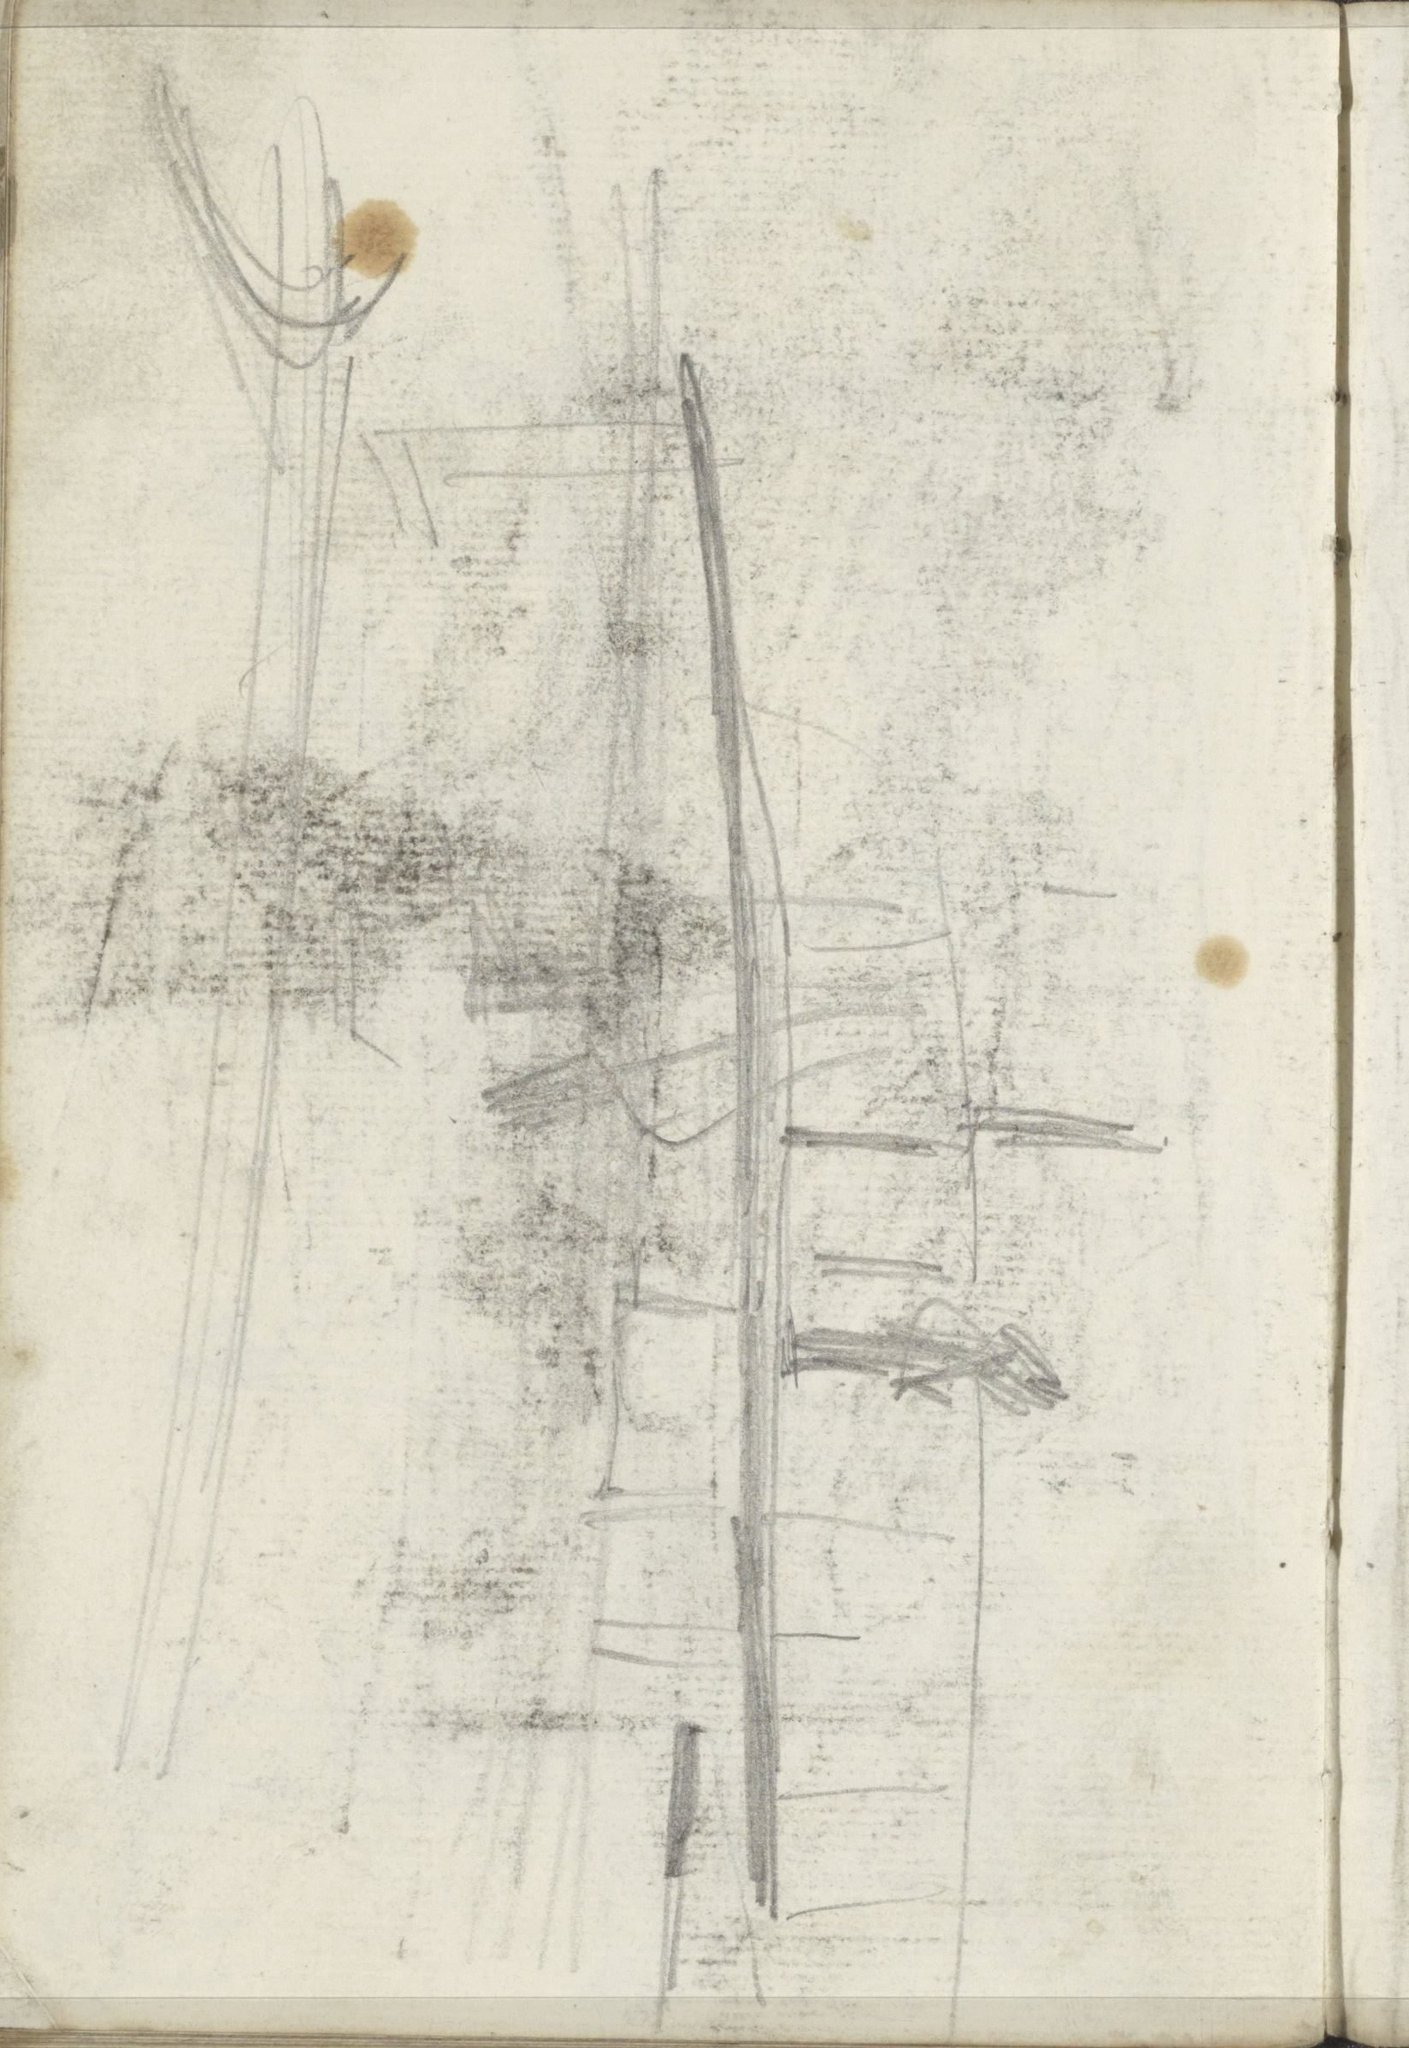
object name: sketchbook leaf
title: Figuur op een brug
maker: george hendrik breitner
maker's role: draughtsman, painter, print maker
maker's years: 1857-1923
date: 1886-1898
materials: paper, pencil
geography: amsterdam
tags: bridge in city across river, canal, etc. (+ city(-scape) with figures, staffage), amsterdam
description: Pagina 39 uit een schetsboek met 21 bladen.